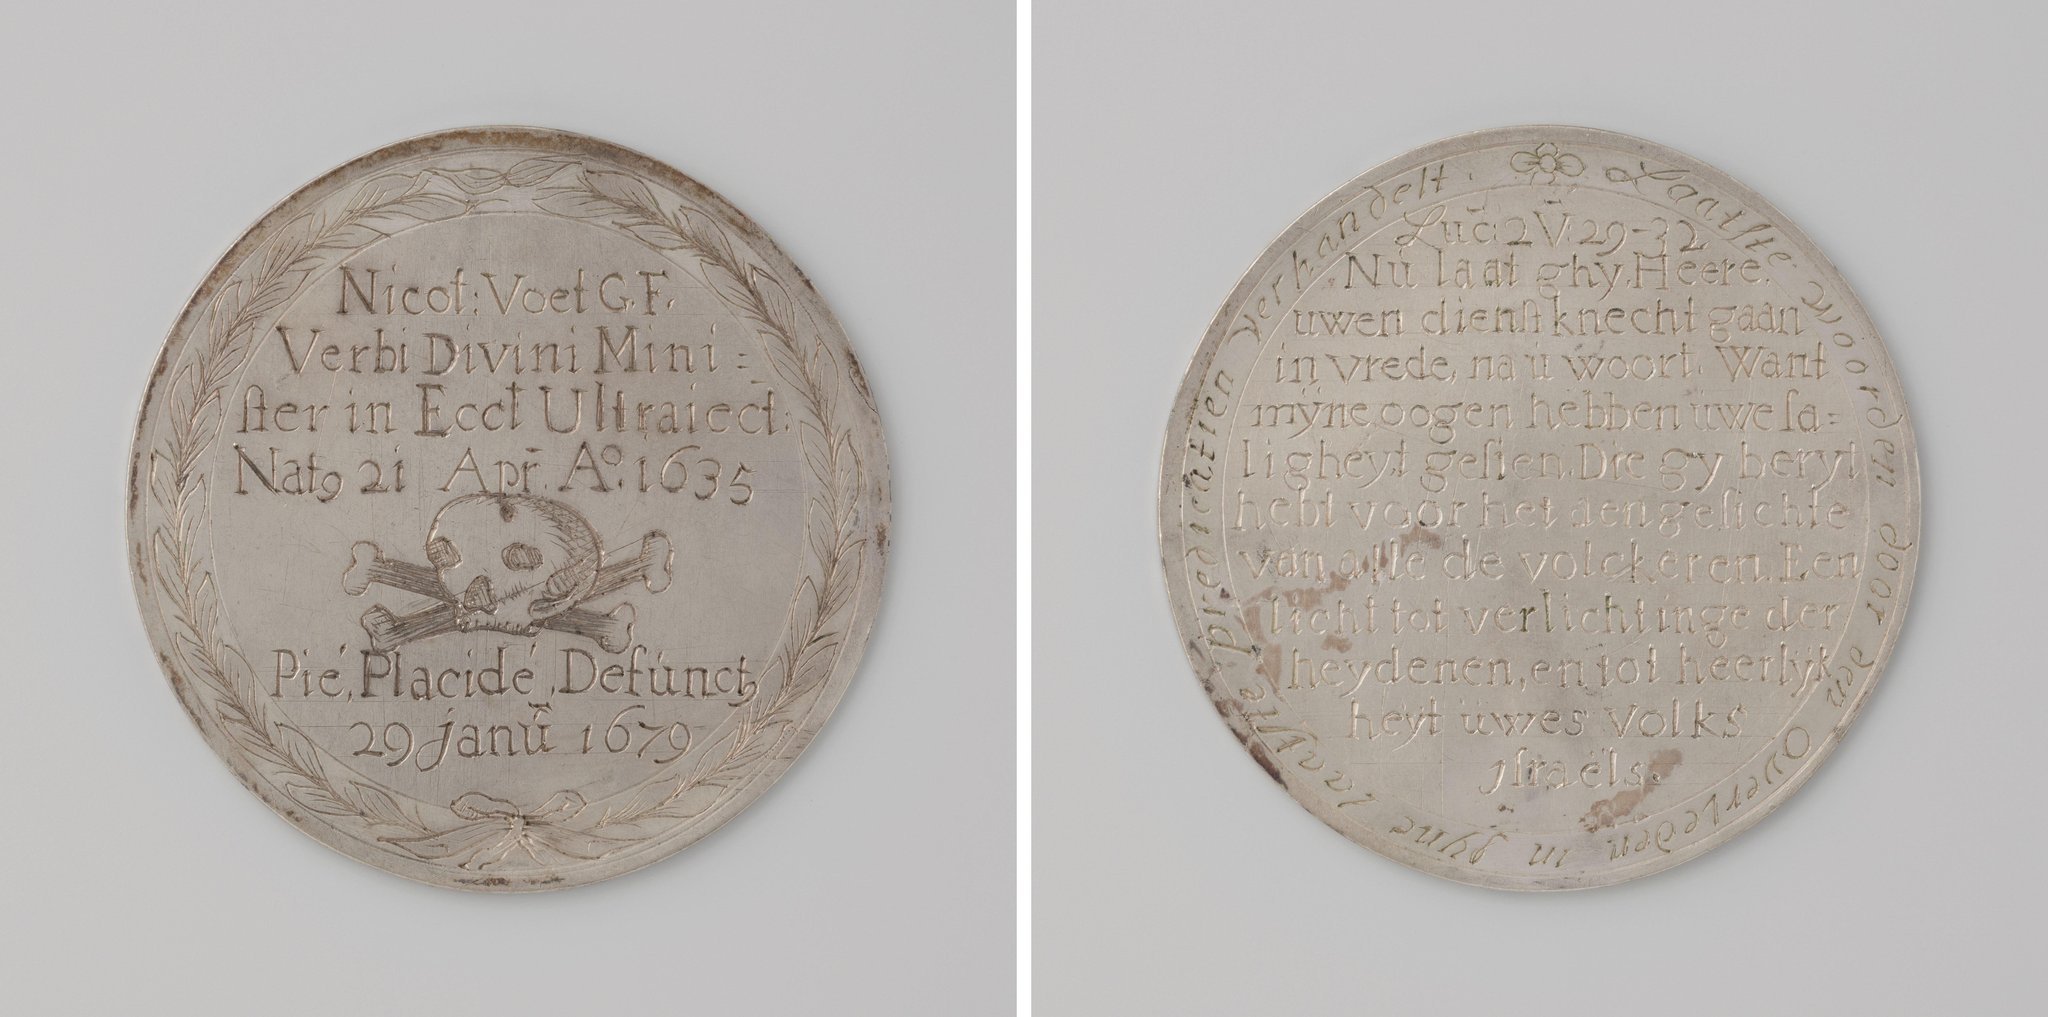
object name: history medal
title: Death of Nicolaas Voet, Minister in Utrecht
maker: Anonymous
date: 1679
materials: silver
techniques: engraving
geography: netherlands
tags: utrecht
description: In the past, important events were graced with a medal, especially in well-to-do families. The occasion for this was usually a birth, wedding, or death. These medals not only remained in the family as a memento, but were also given to the guests at the baptism, wedding party, or funeral. Sometimes they were purely private in character, such as the gold medal a grandfather gave to his grandson.